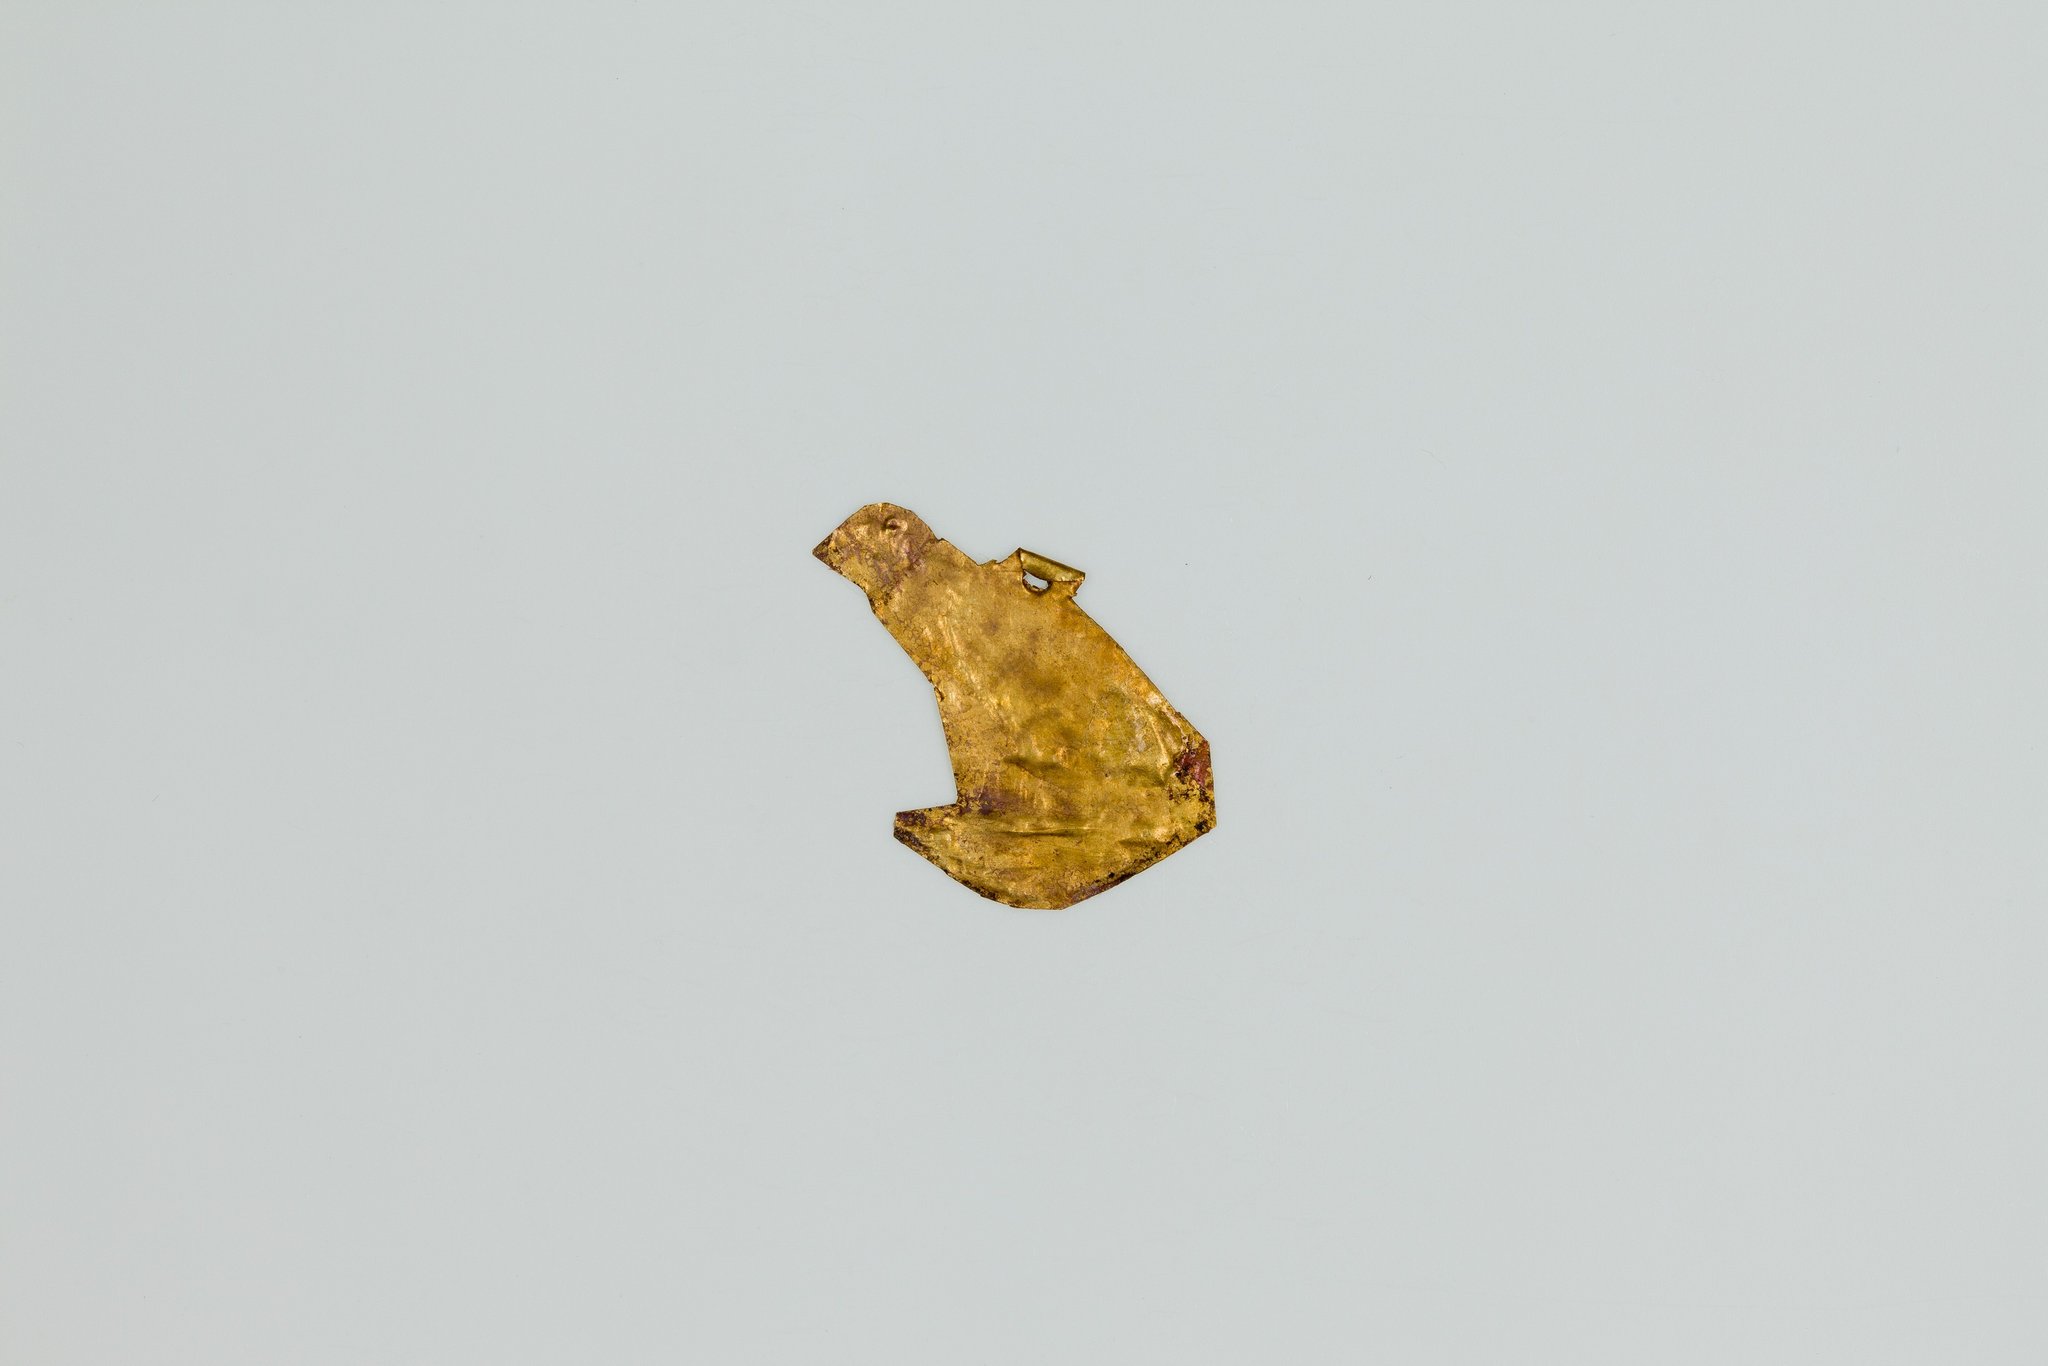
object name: amulet, nekhbet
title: Nekhbet amulet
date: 664-380 BCE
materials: gold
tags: goddess